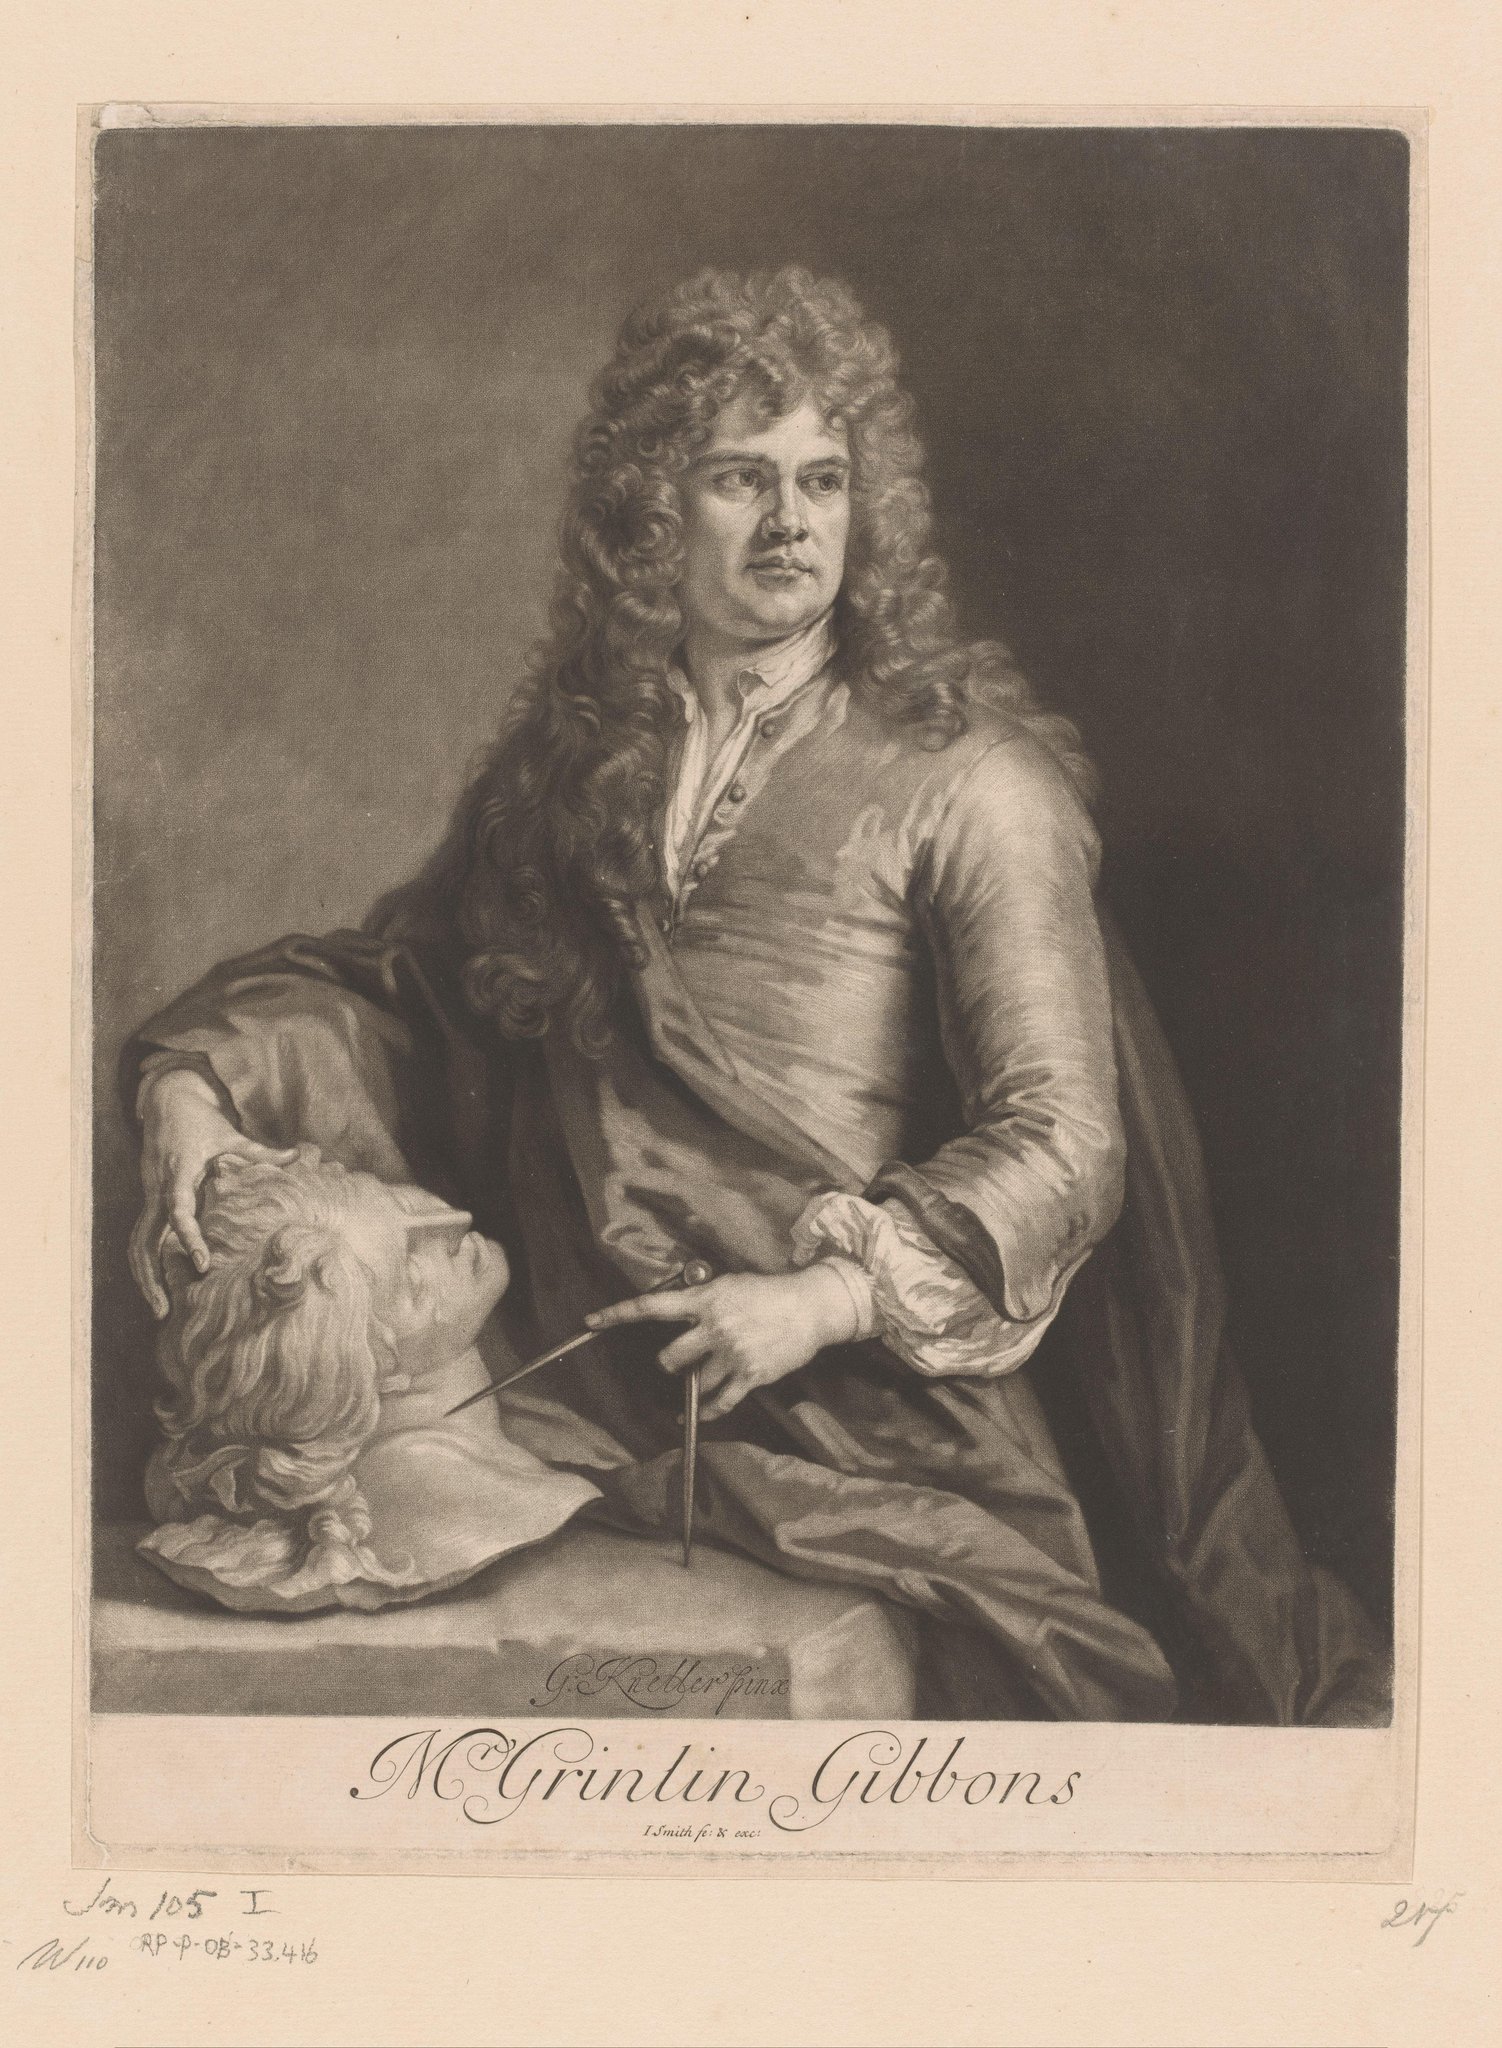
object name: print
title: Portret van Grinling Gibbons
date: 1662-1742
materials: paper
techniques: mezzotint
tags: rotterdam, london, sculptor, grinling gibbons, portrait, self-portrait of sculptor, historical persons, compasses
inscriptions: collector's mark: Lugt 240